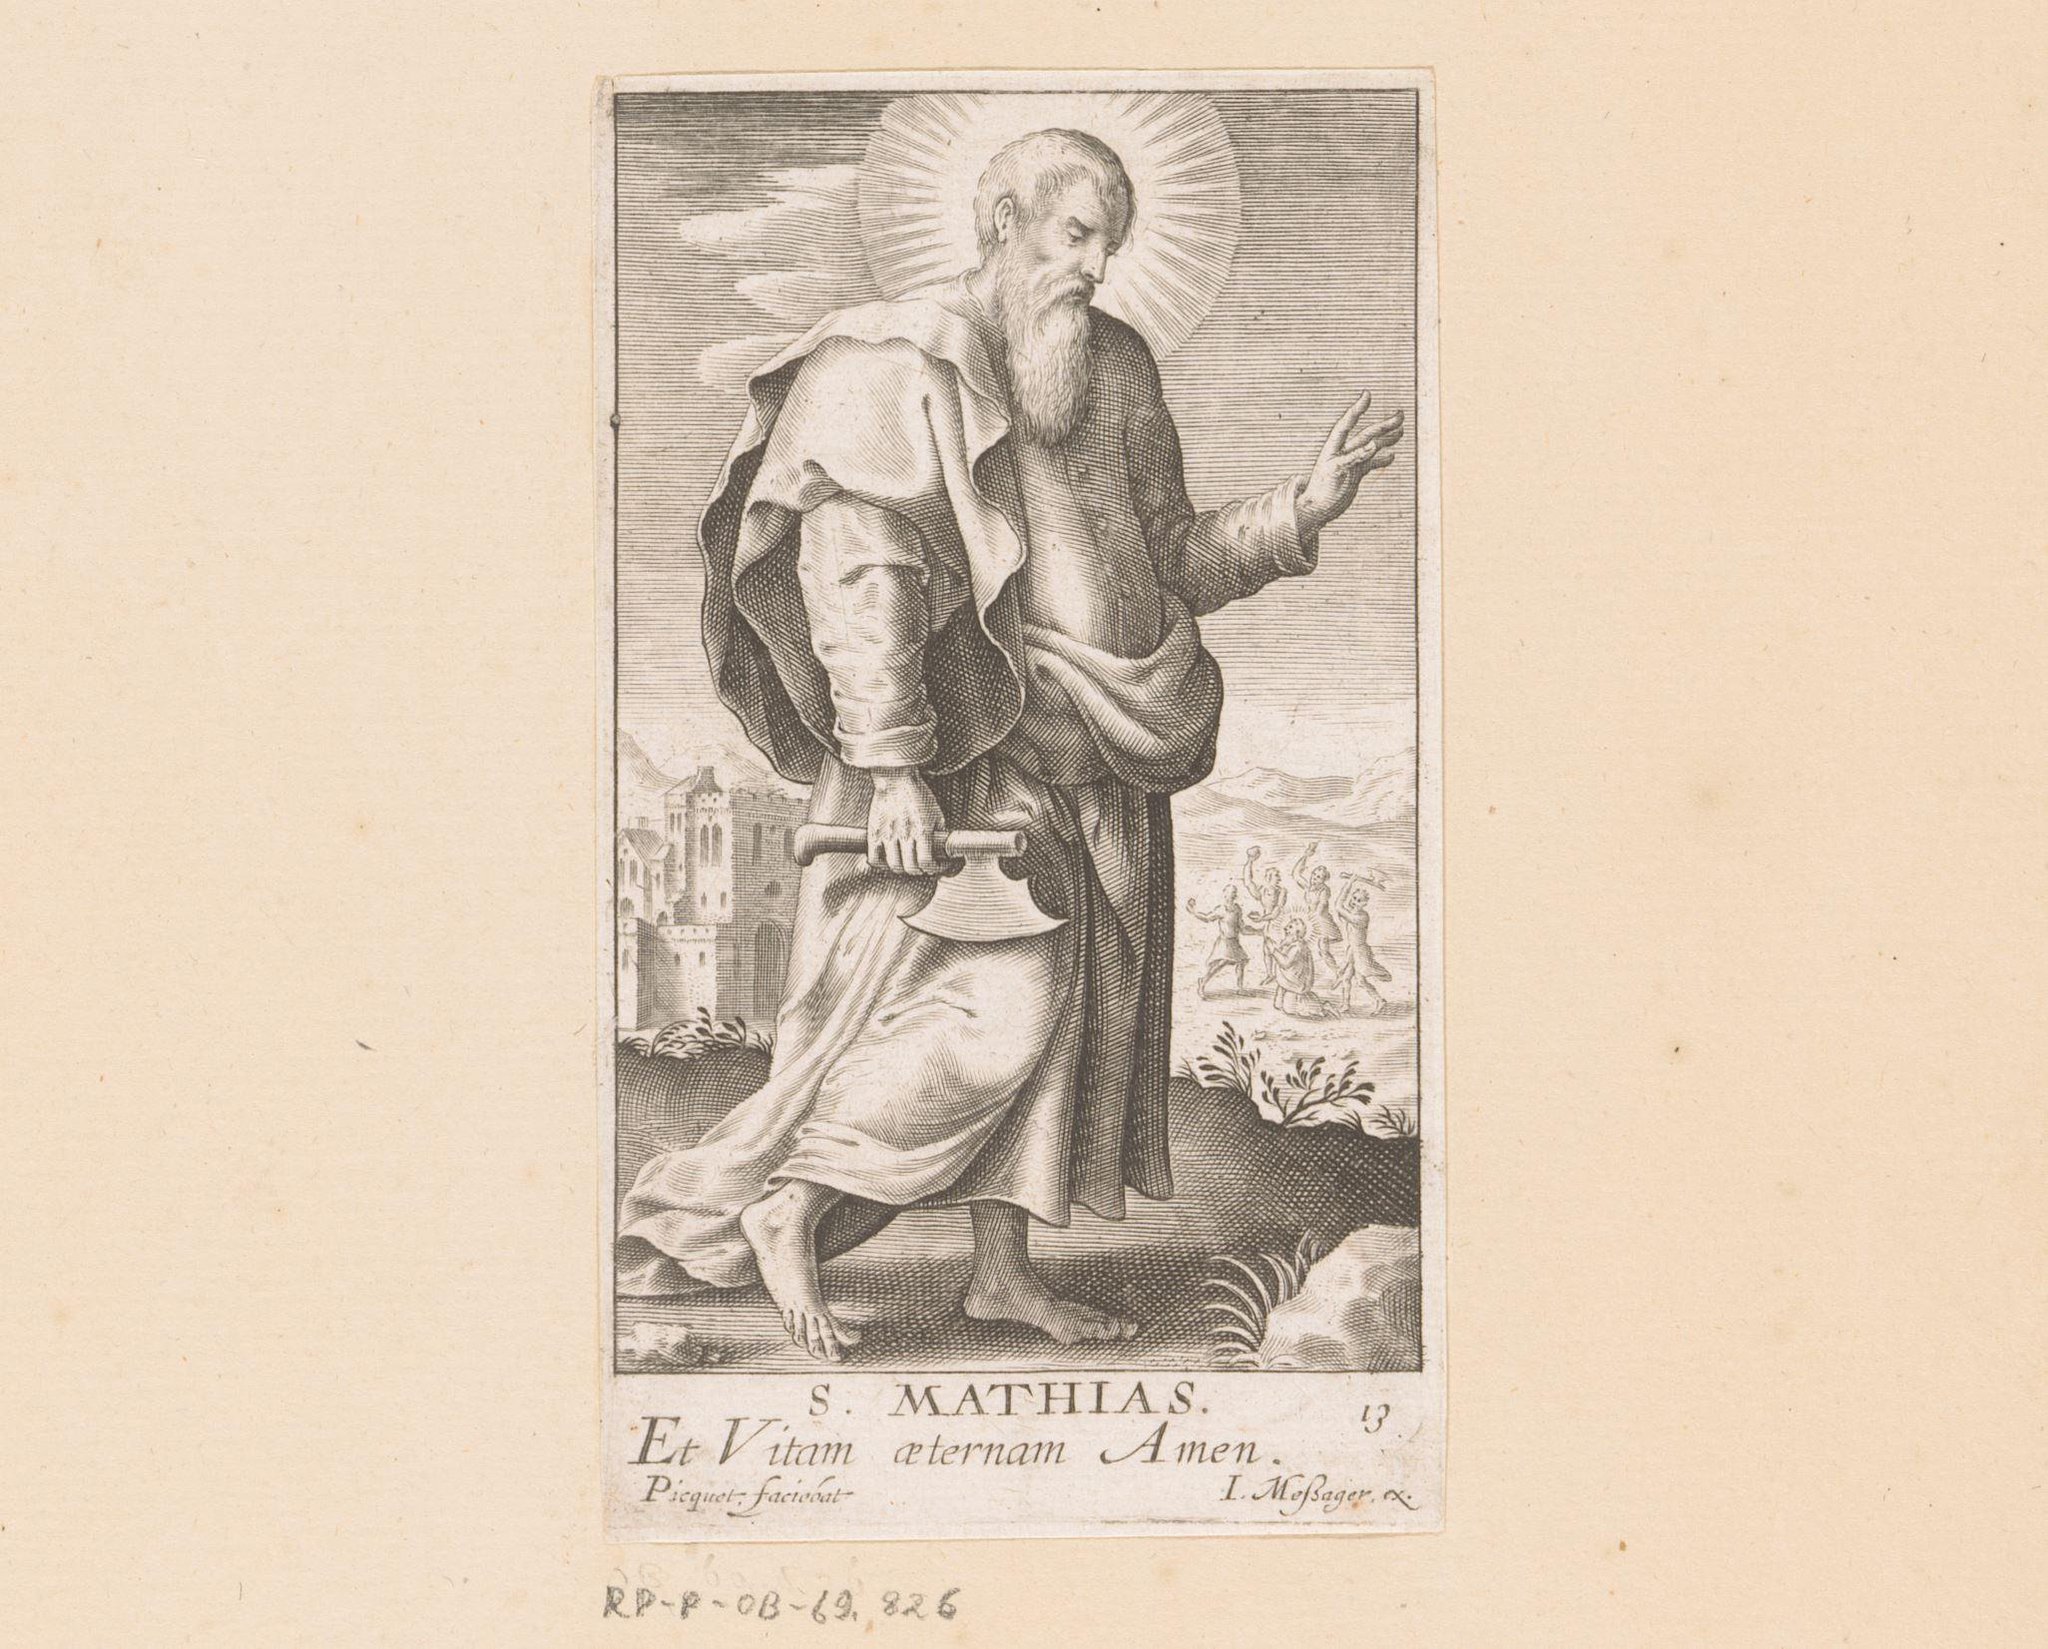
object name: print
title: S. Mathias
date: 1608-1649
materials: paper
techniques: engraving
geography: france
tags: the apostle and martyr matthias; possible attributes: axe, book, cross, halberd, scroll, sword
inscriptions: collector's mark: Lugt 240